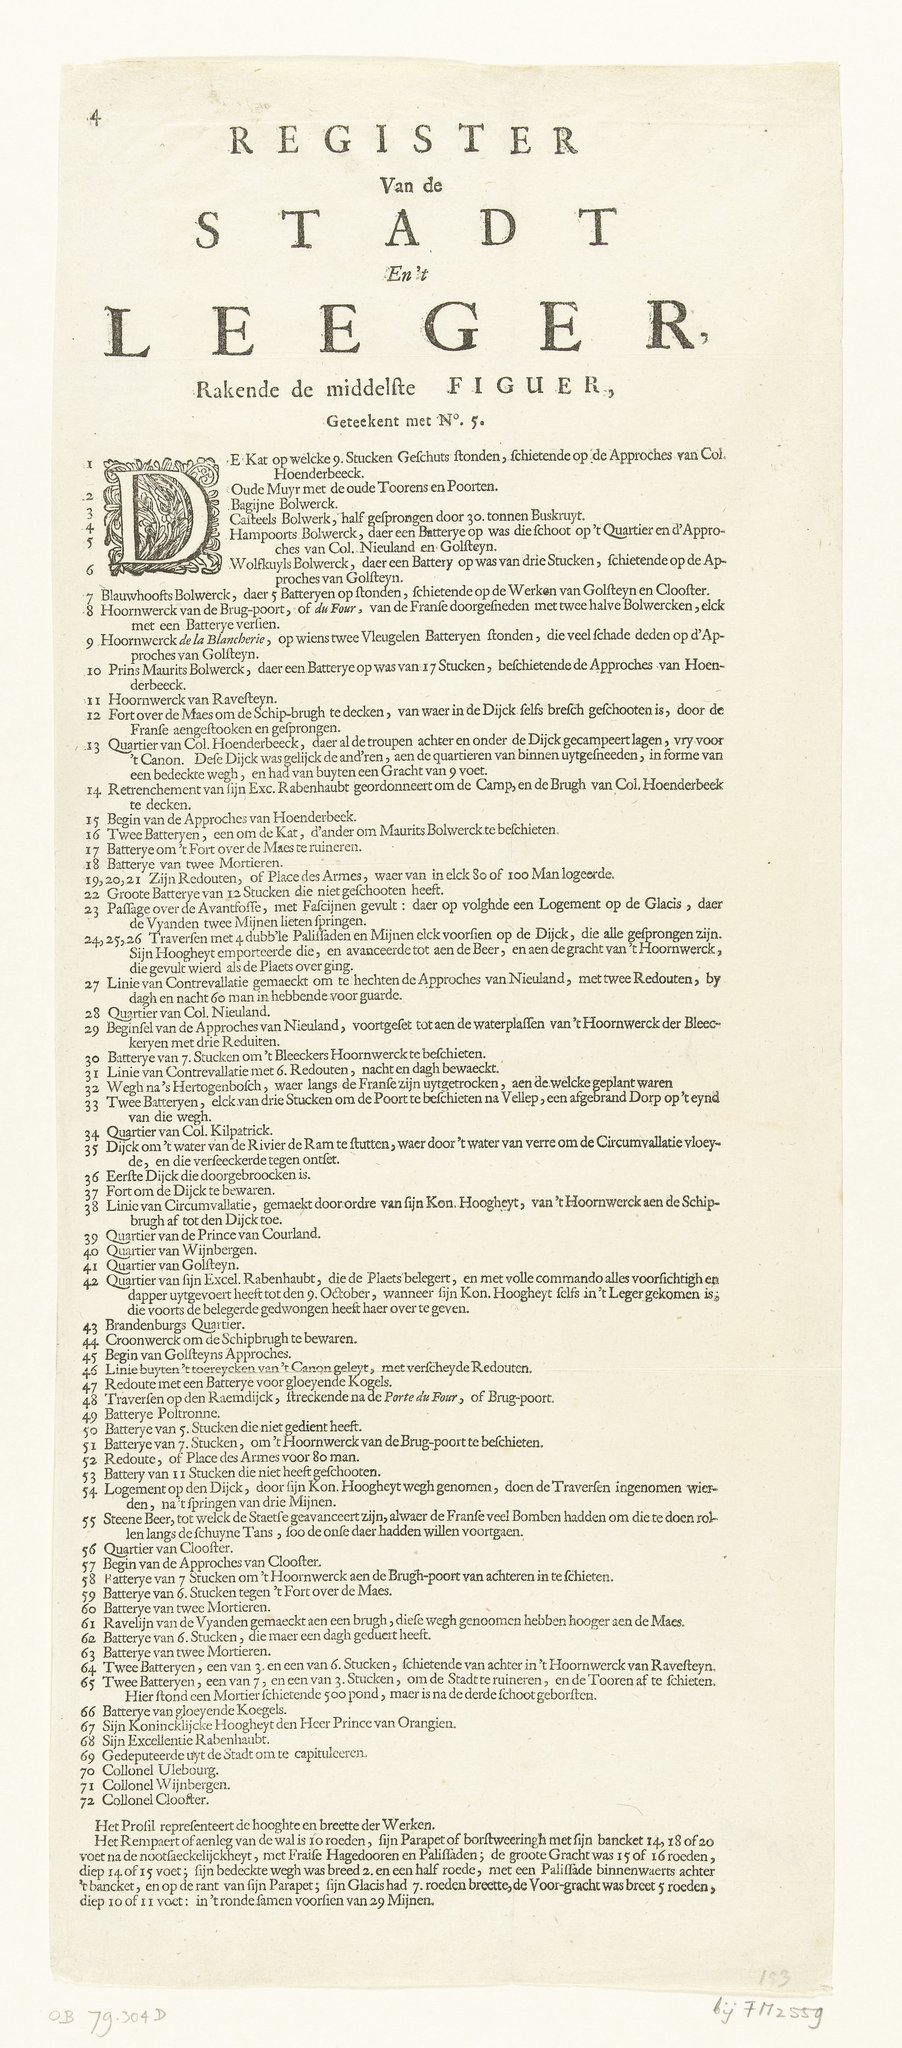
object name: print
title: Legenda bij het beleg en de verovering van Grave door Willem III, 1674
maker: romeyn de hooghe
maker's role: draughtsman, goldsmith, painter, print maker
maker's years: 1645-1708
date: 1674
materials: paper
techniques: letterpress printing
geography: amsterdam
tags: william iii (prince of orange and king of england, scotland, and ireland), grave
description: Legenda bij het beleg en de verovering van Grave door Willem III, 25 juli tot 29 oktober 1674. Kolom genummerd 4 met de legenda 1-72. Onderdeel van de uitvoerige voorstelling en beschrijving van deze gebeurtenissen in 2 bladen met 1 grote voorstelling en 6 kleinere voorstellingen. Hierbij ook enkele tekstbladen.